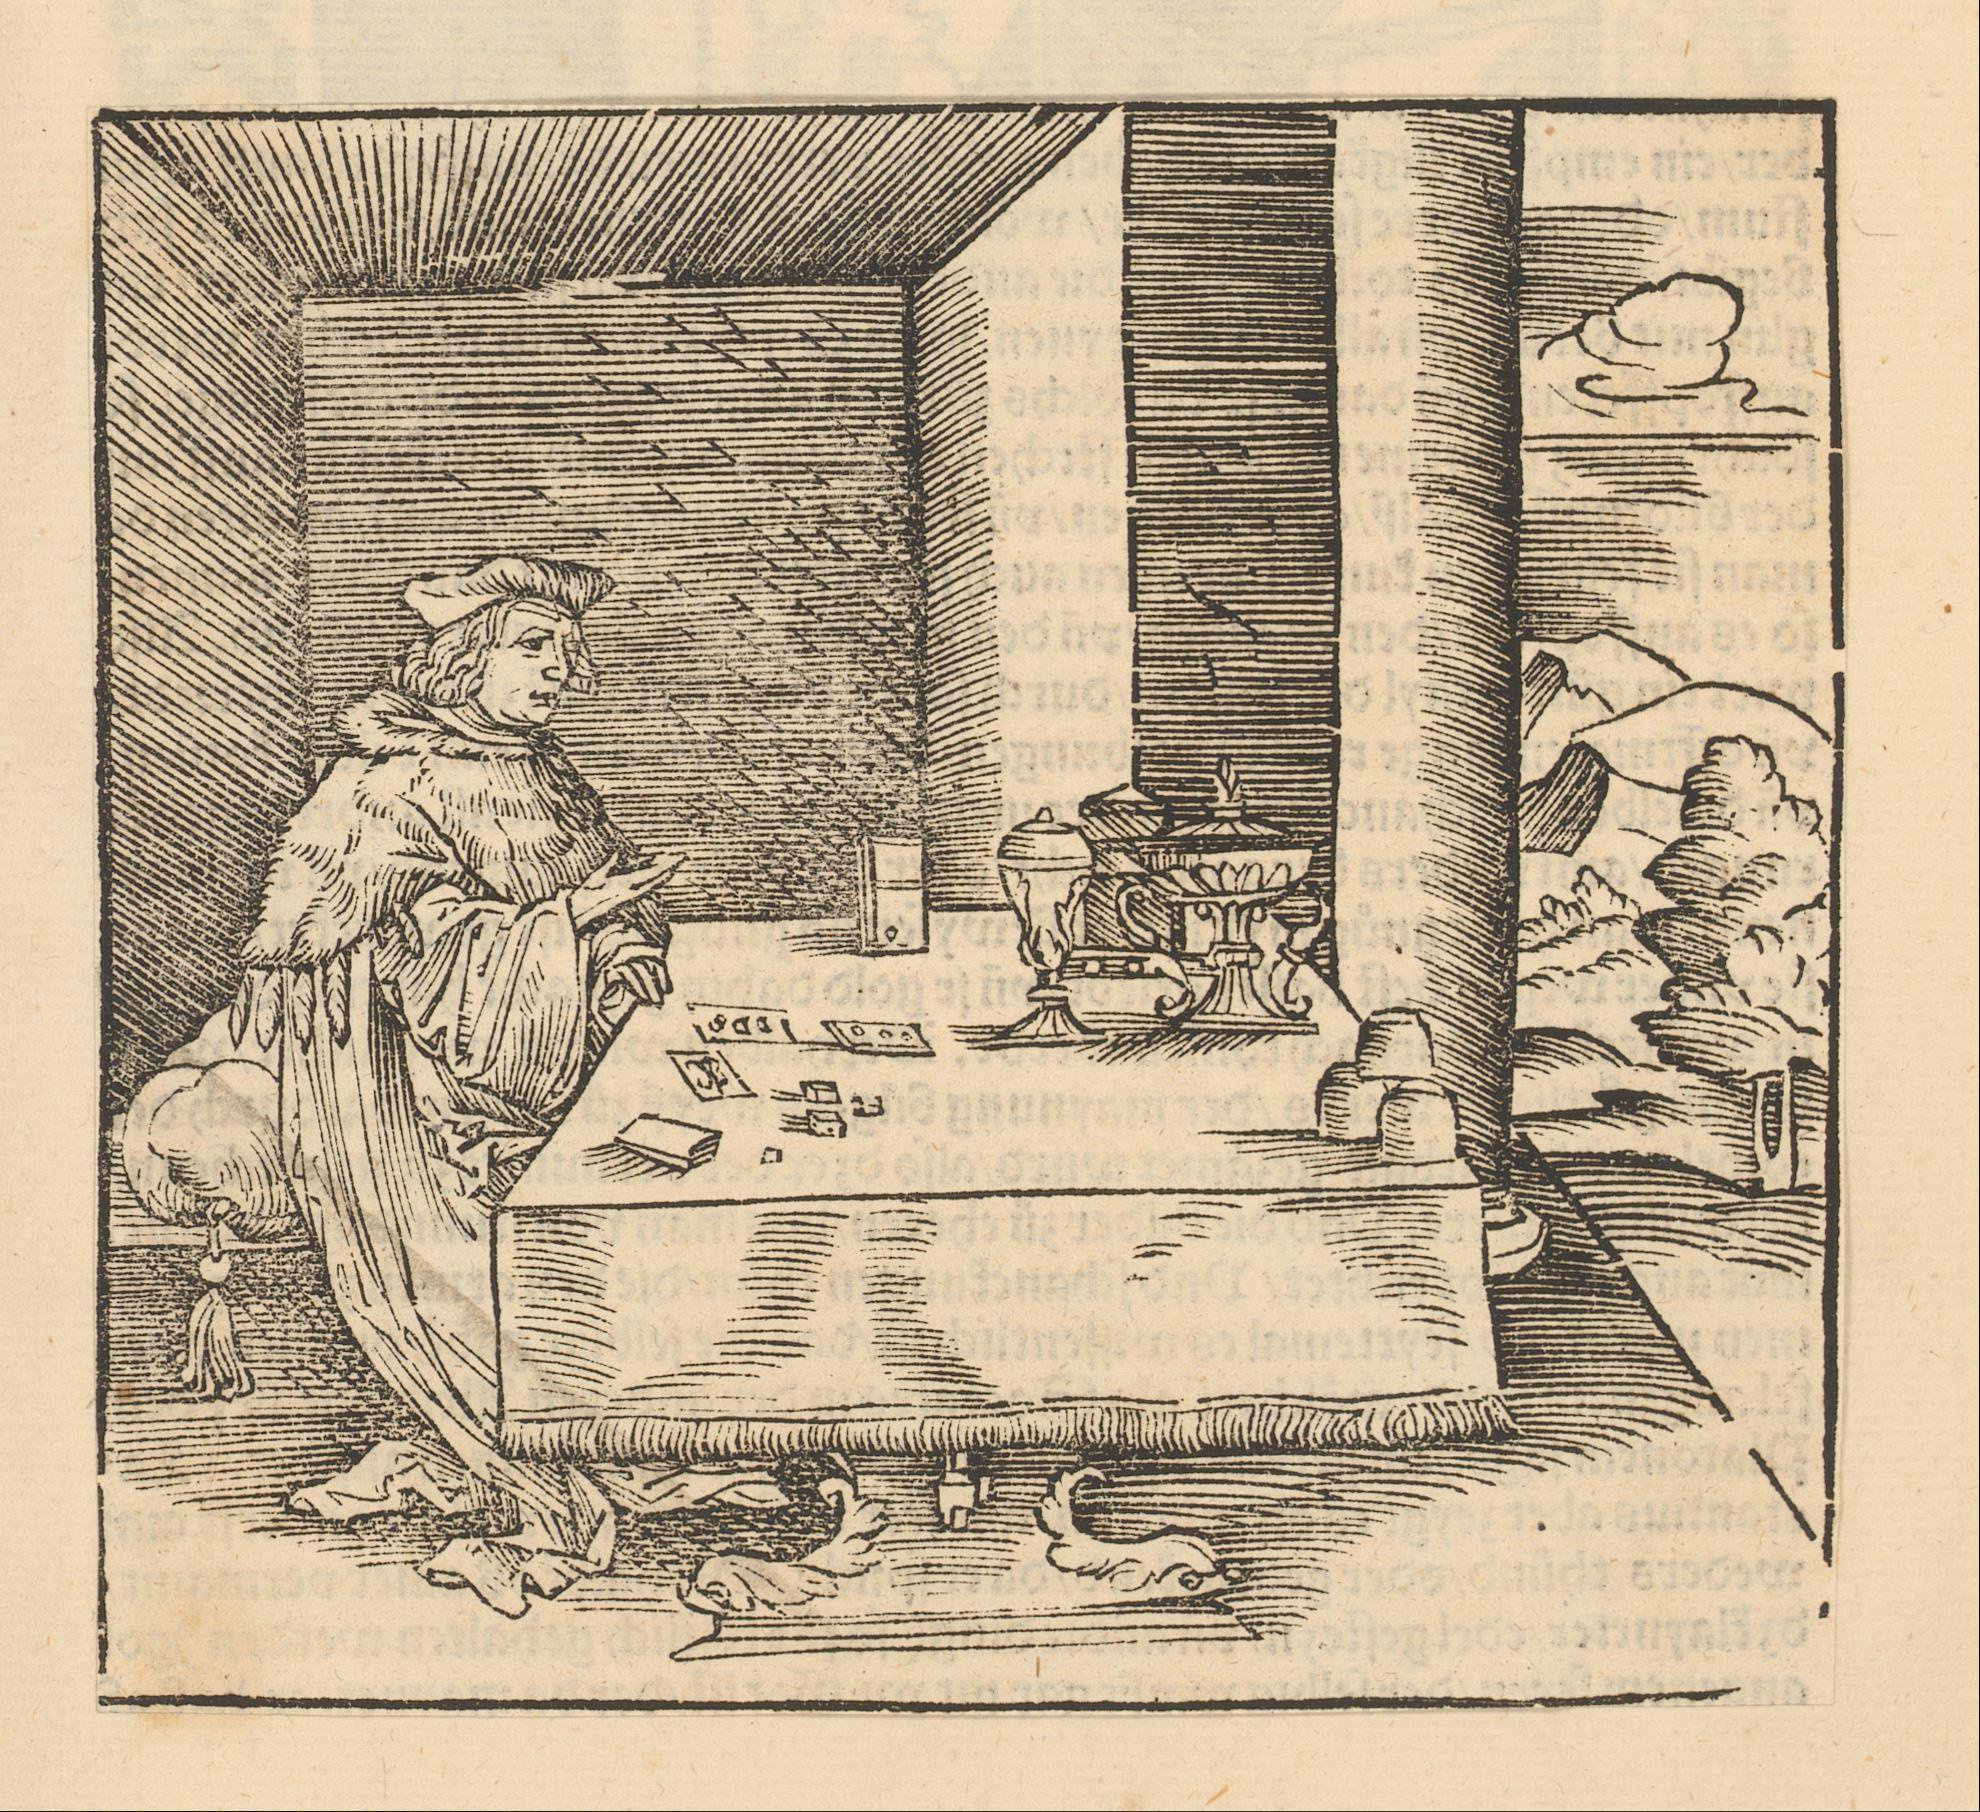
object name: book illustration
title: Man met kaarten en dobbelstenen aan tafel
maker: Anonymous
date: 1490-1534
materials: paper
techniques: letterpress printing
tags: games of calculation and chance, e.g.: card games, gambling, puzzles, etc.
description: Prent is gebruikt in: Teütsch Cicero. [Vertaald uit het Latijn door] Johannes von Schwarzenberg. Augsburg: Hans Steiner, 1534.